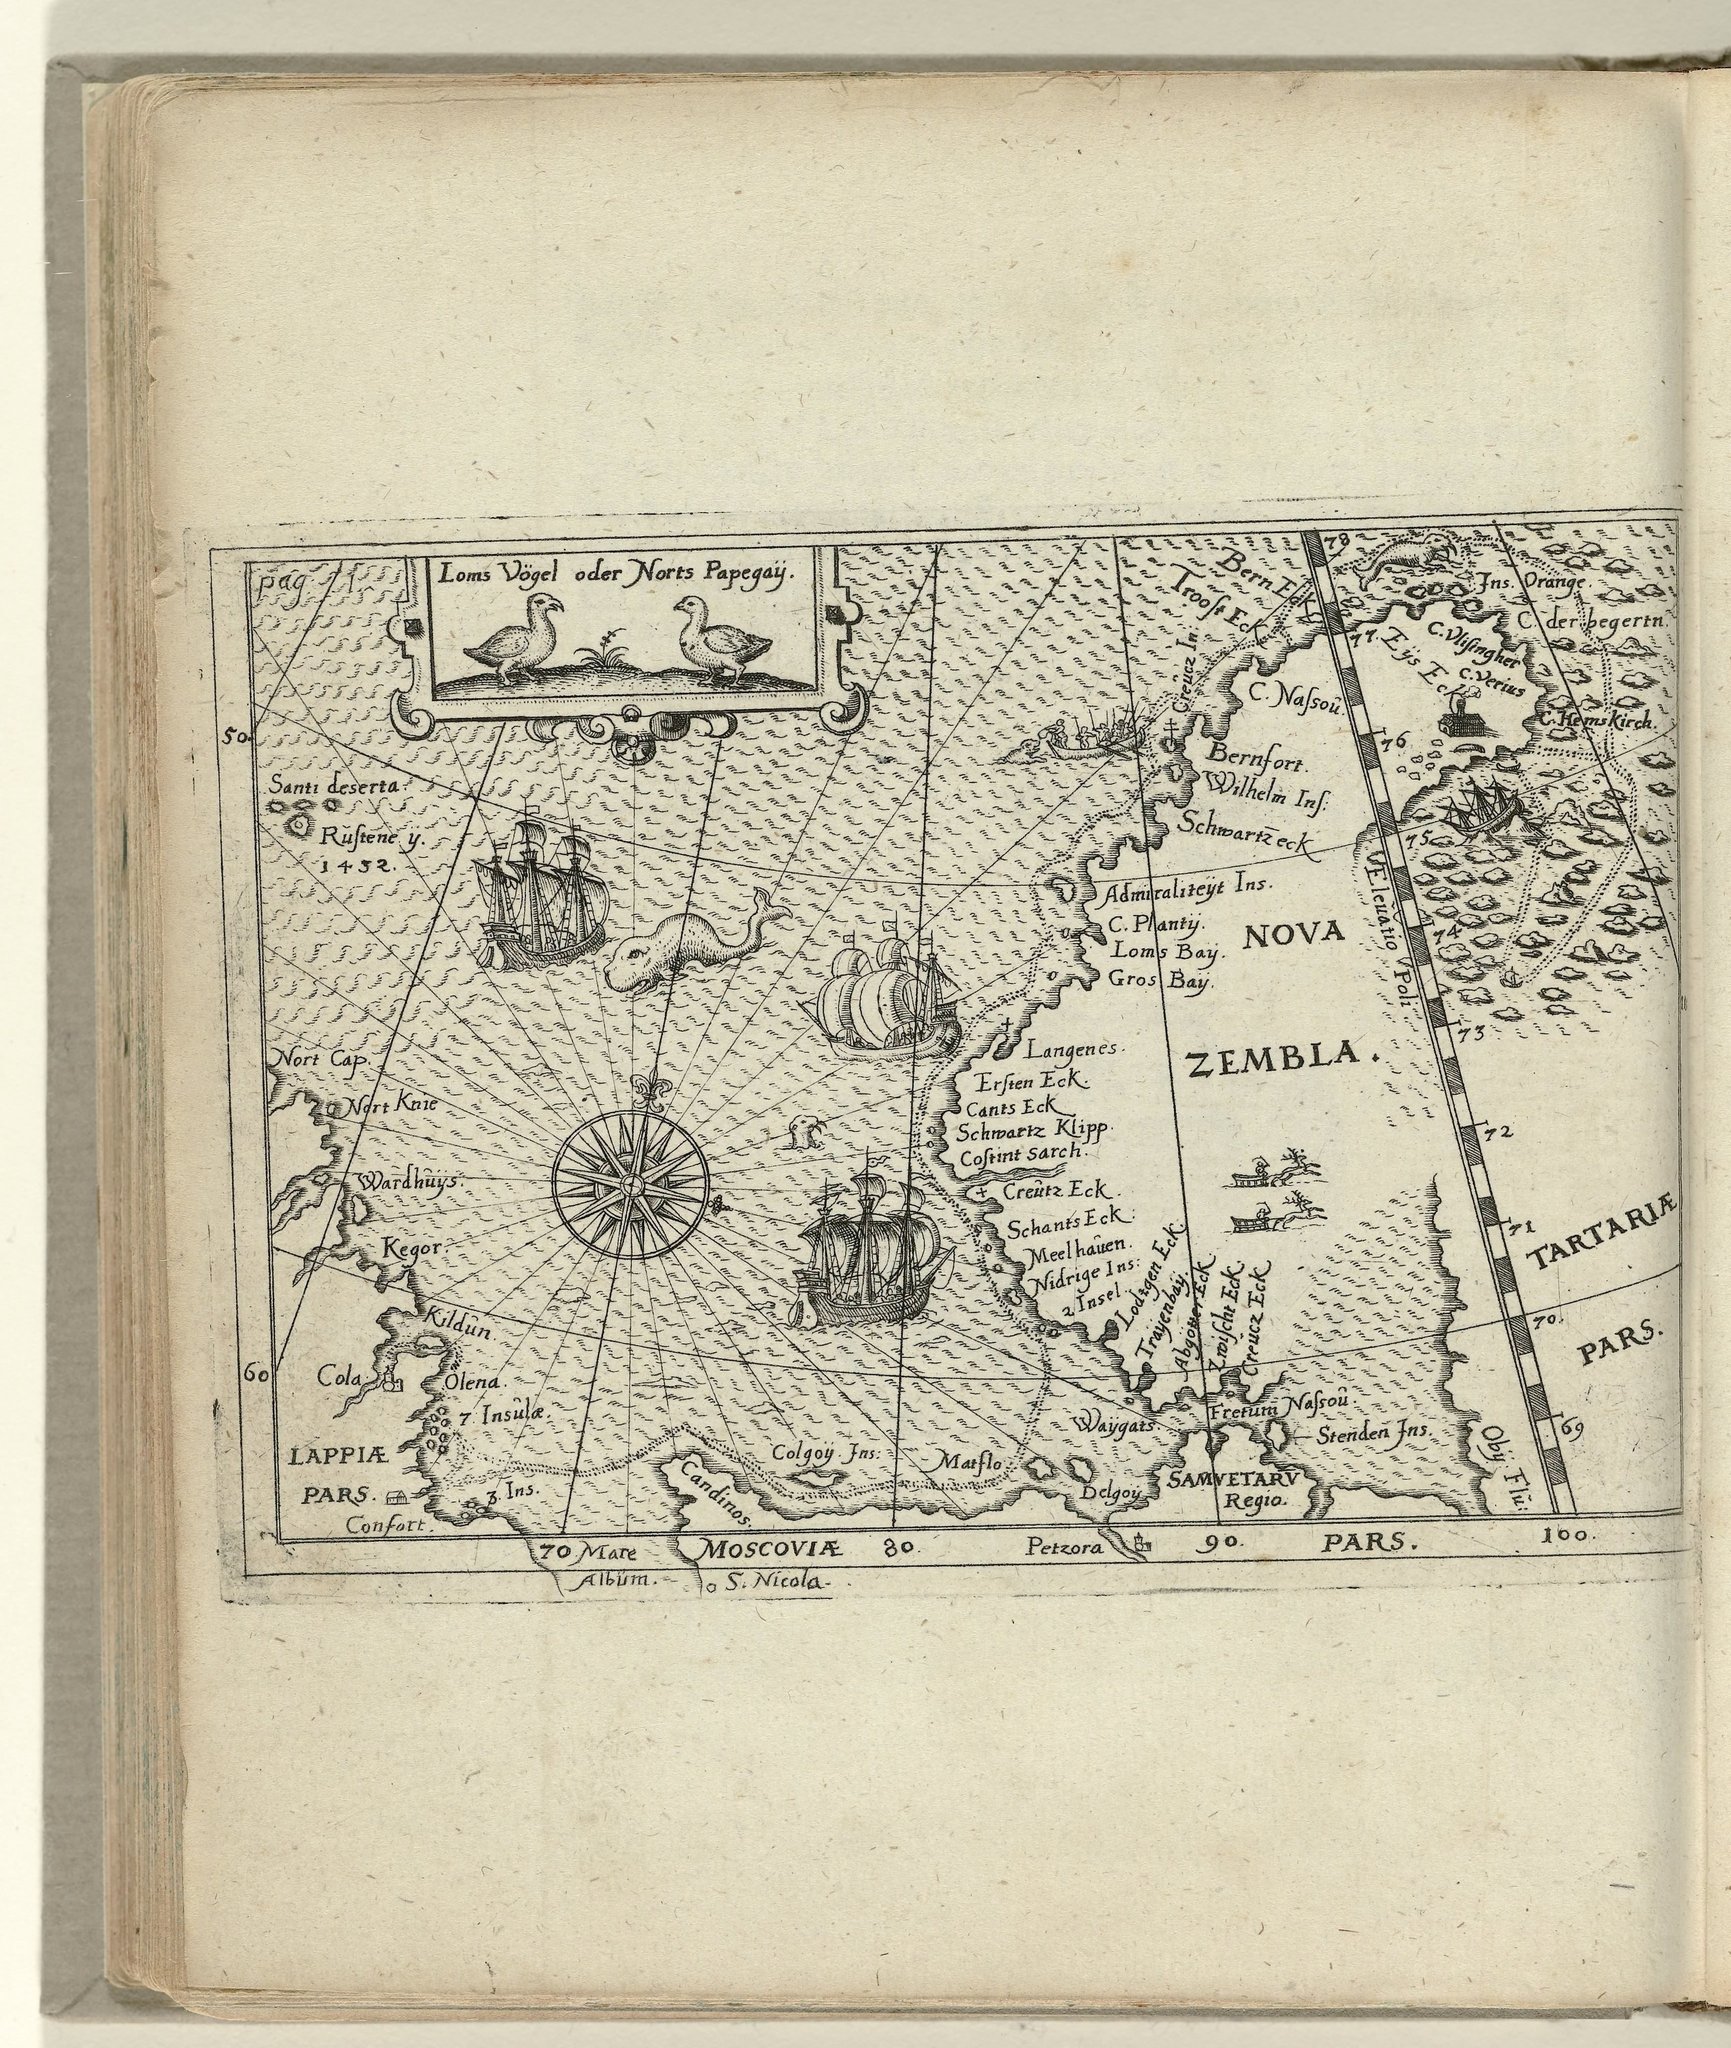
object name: print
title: Kaart van Nova Zembla, 1594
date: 1598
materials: paper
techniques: engraving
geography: nuremberg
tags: willem barendsz., amsterdam, jacob van heemskerck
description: Kaartje van de westkust van Nova Zembla, het gebied verkend tijdens de eerste reis in 1594. Bovenin een cartouche met twee vogels. Tegenover pagina 1 in: 'Warhafftige Relation. Der dreyen newen unerhörten seltzamen Schiffart so die Holländischen und Seeländischen Schiff....Anno 1594, 1595 und 1596 verricht' (1598).